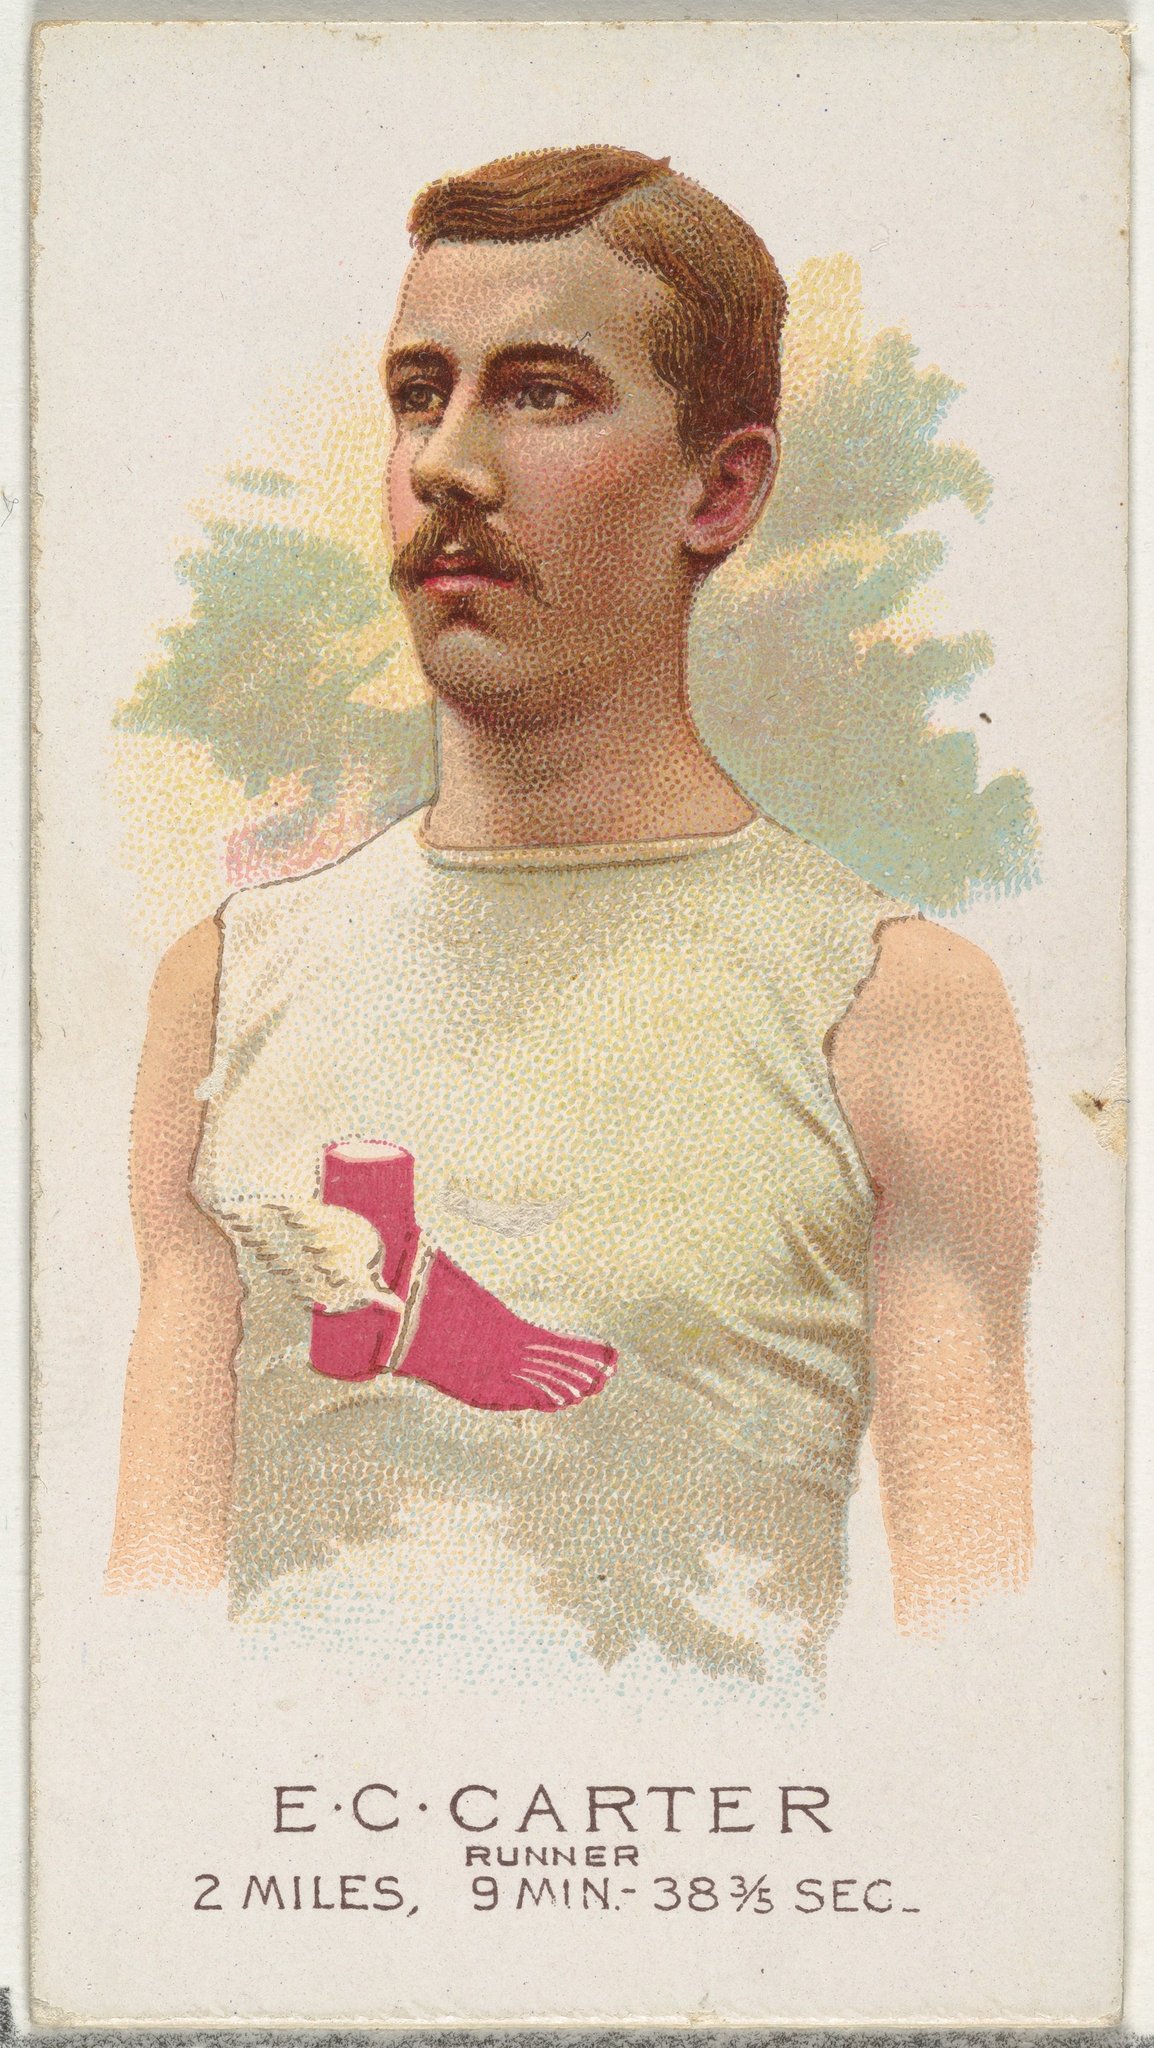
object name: print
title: E.C. Carter, Runner, from World's Champions, Series 2 (N29) for Allen & Ginter Cigarettes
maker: allen & ginter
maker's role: publisher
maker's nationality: american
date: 1888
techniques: color lithograph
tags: men,portraits,athletes